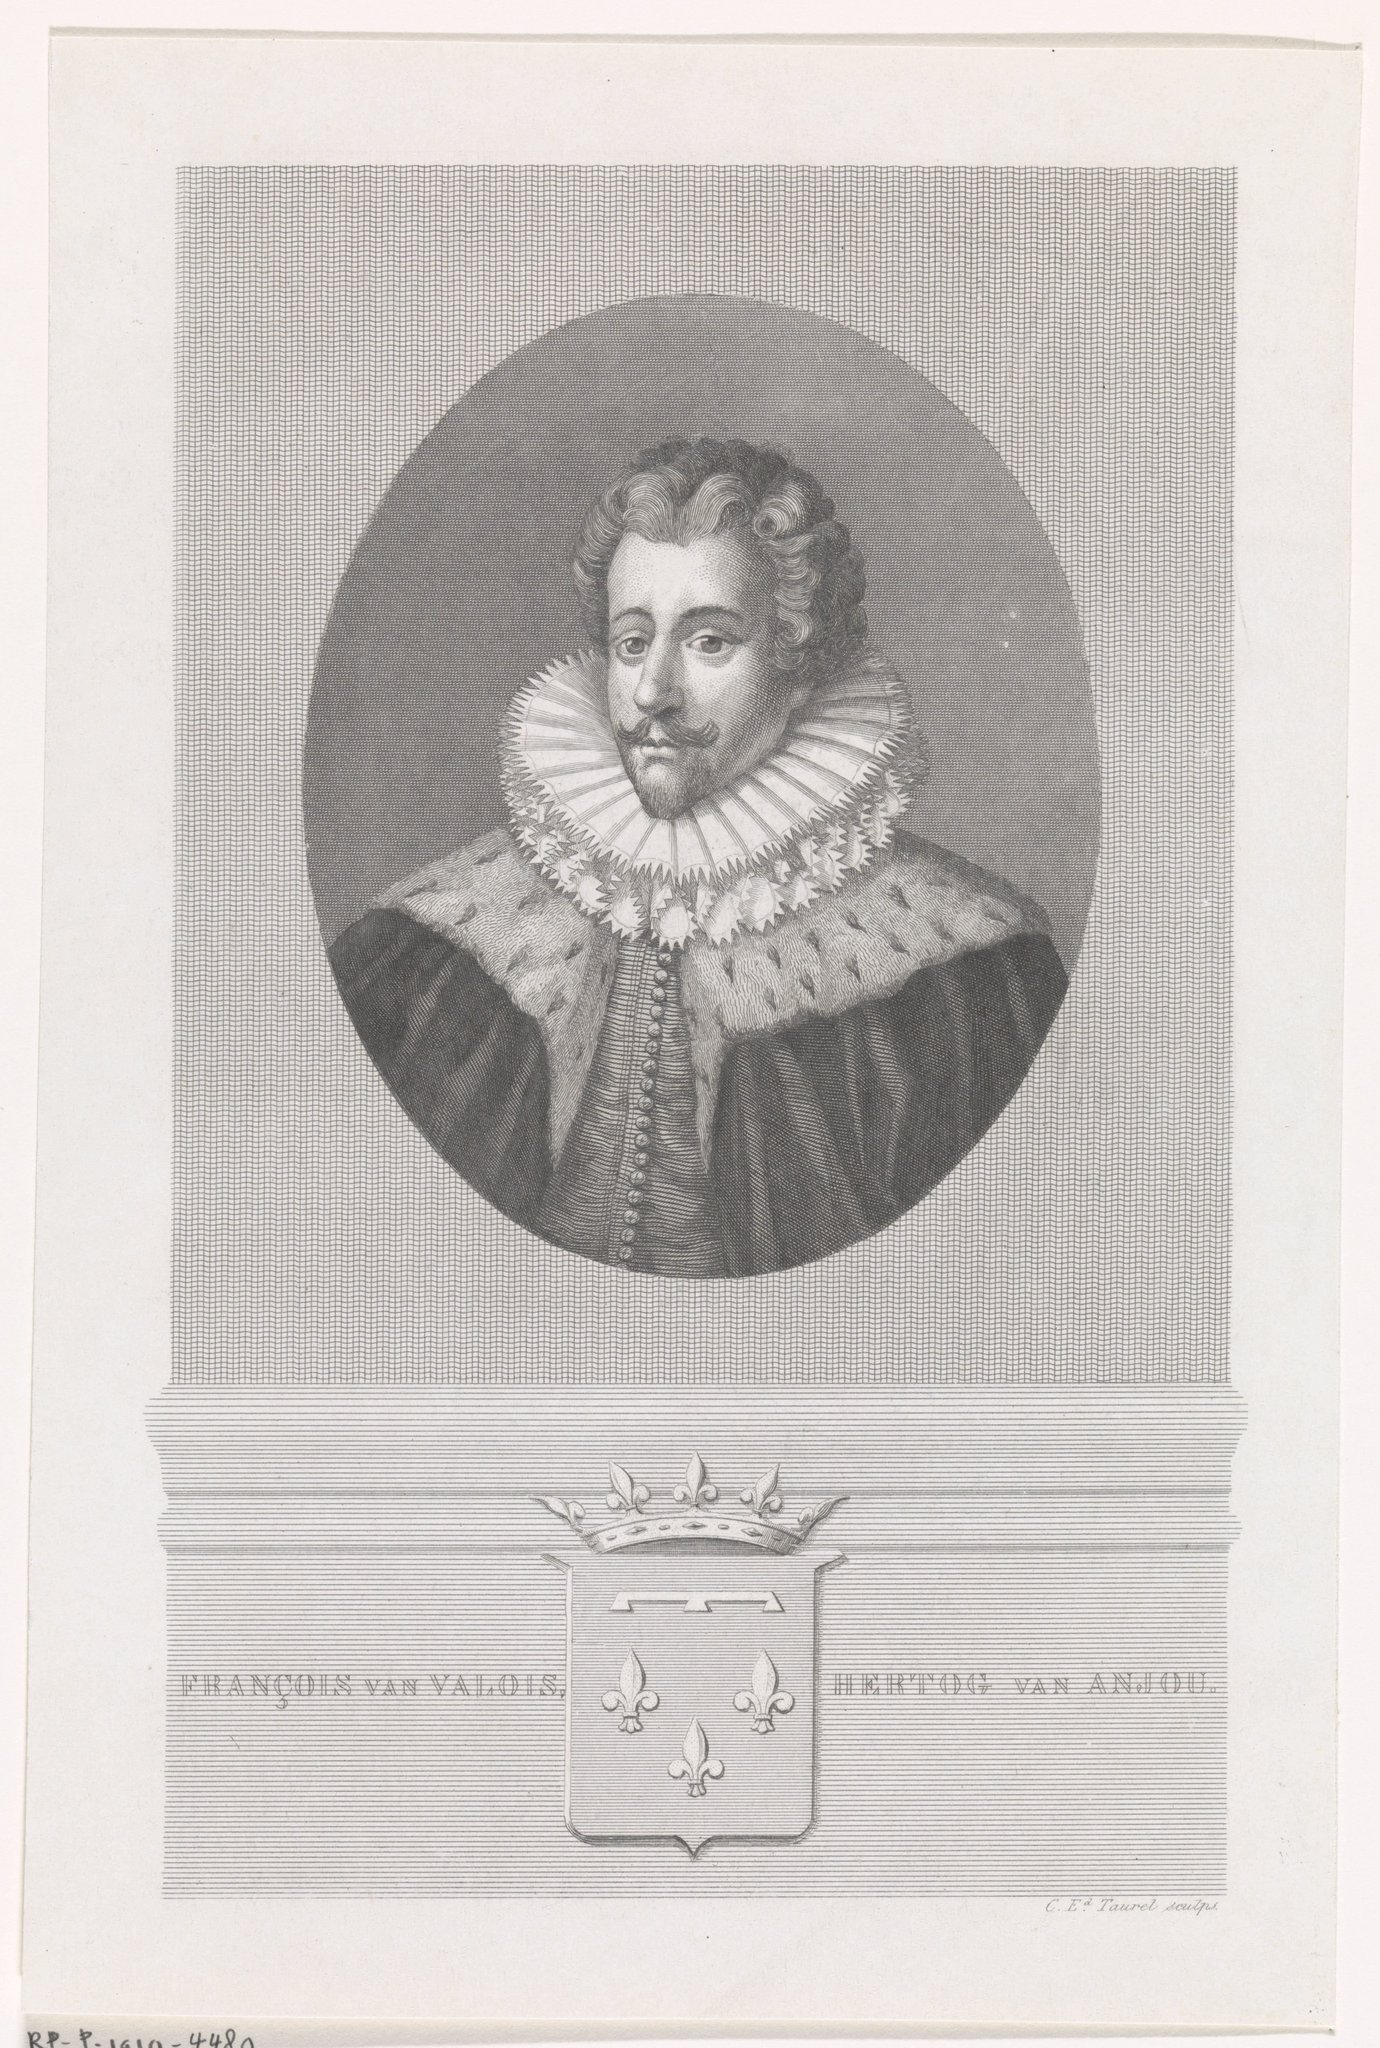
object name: print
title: Portret van François-Hercule de Valois, hertog van Anjou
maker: edouard taurel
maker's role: draughtsman, print maker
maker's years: 1824-1892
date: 1841-1879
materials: paper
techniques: engraving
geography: amsterdam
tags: paris, françois-hercule de valois (hertog van anjou)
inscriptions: collector's mark: Lugt 2228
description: Prent ook gebruikt als illustratie voor: Arend, Johannes Pieter. Algemeene geschiedenis des vaderlands van de vroegste tijden tot op heden. 5 delen. Amsterdam: J.F. Schleijer, 1841-1884. dl. II.6, p. 442.